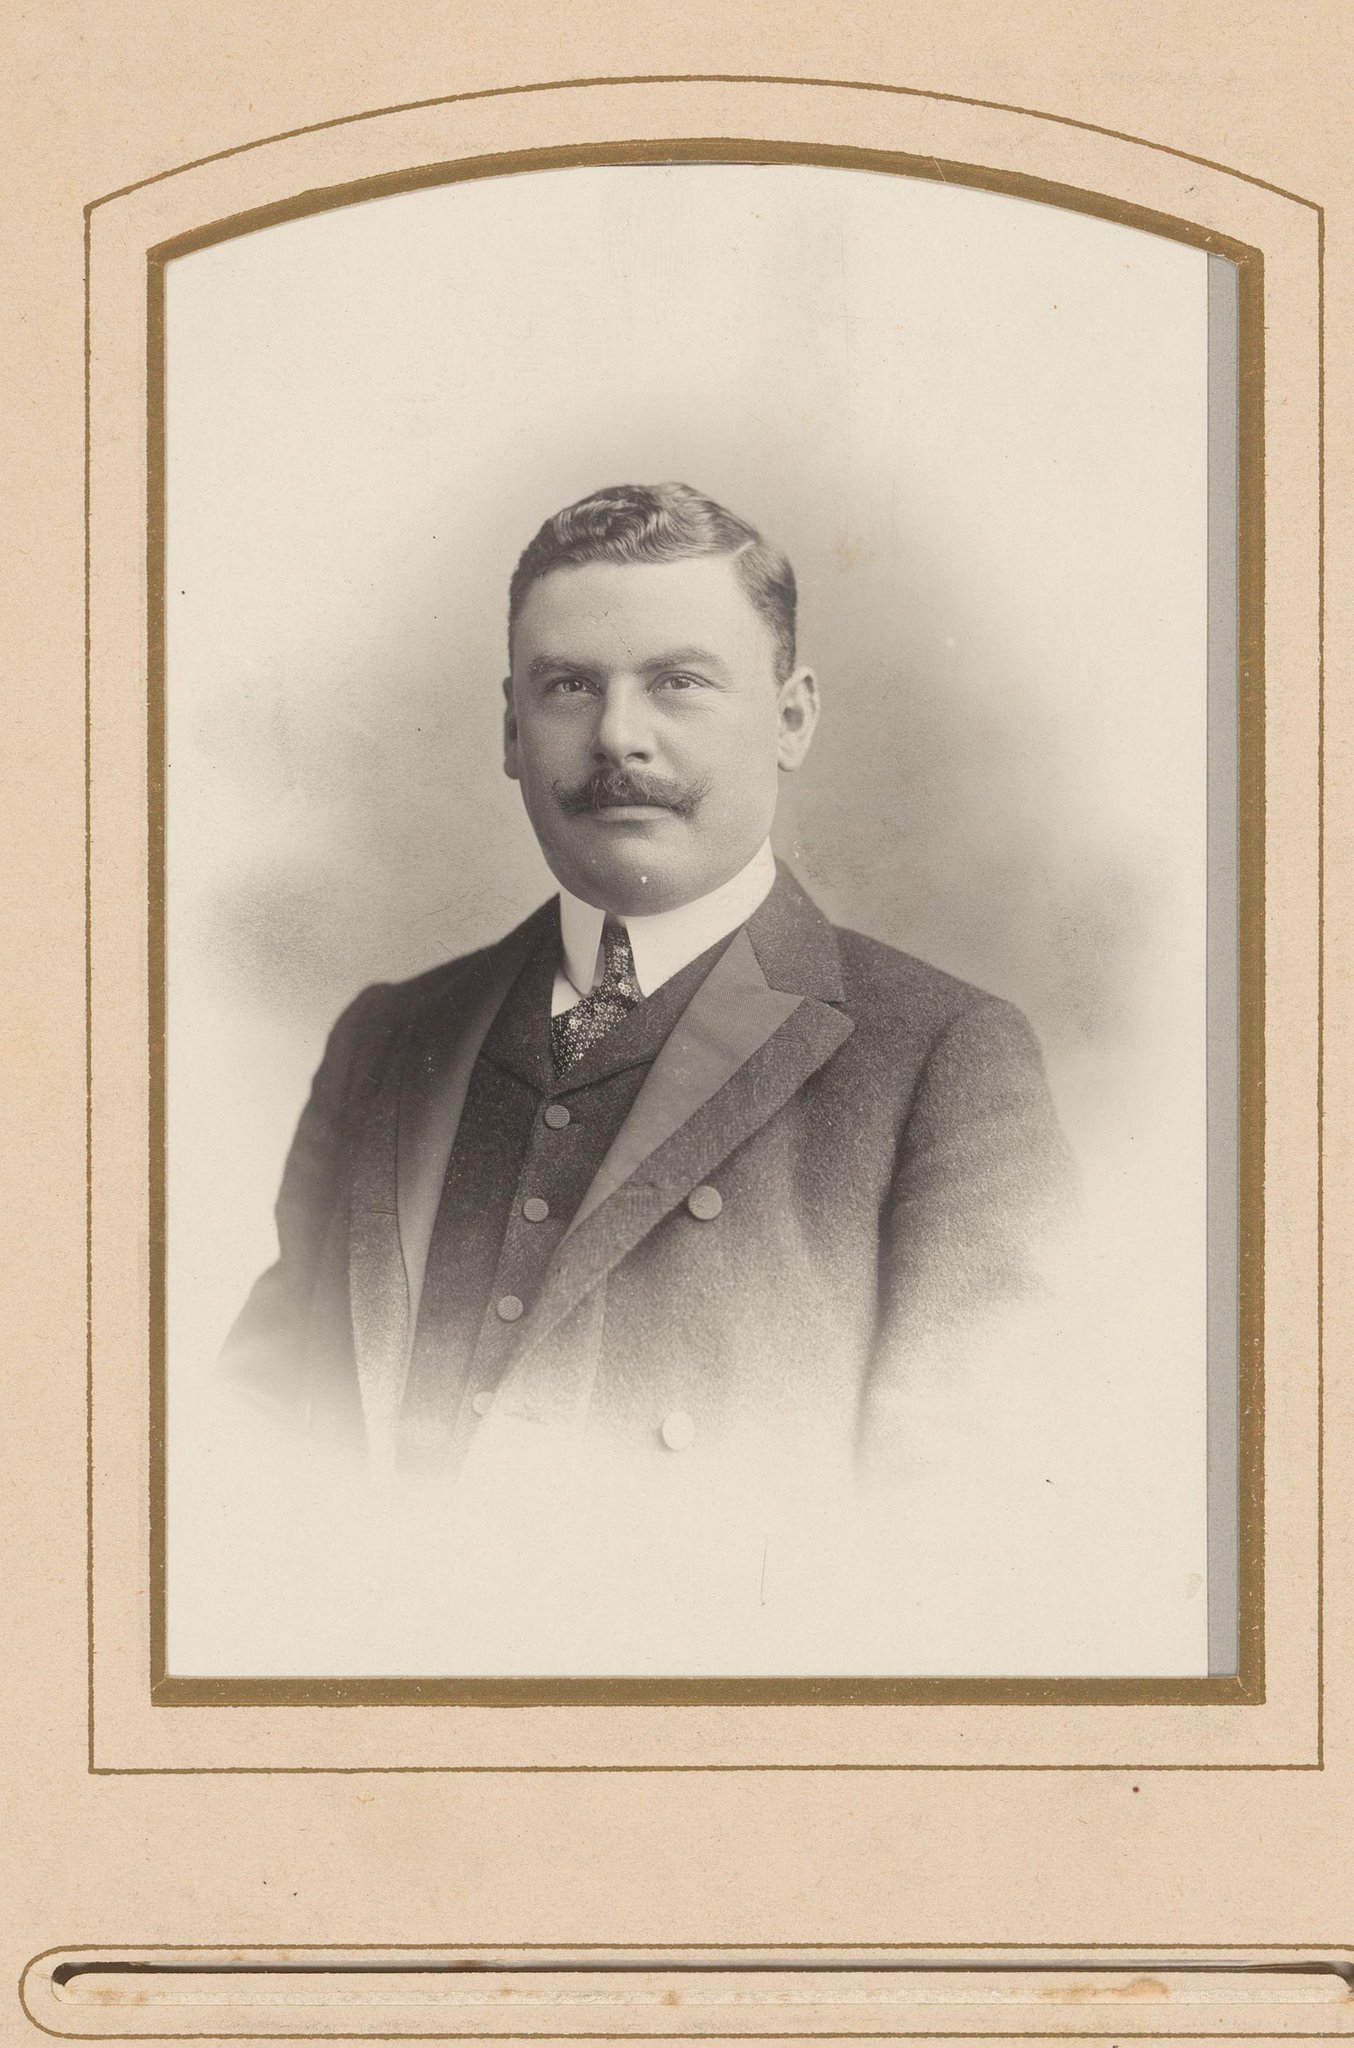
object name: cabinet photograph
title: Portret van een man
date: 1903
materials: cardboard, photographic support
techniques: gelatin silver print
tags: moustache, adult man, historical persons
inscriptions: inscription: ‘57 St Pauls Churchyard/ 61 Cheapside E.C. Emberson&Sons 11 Wilton Rd S.W./ and Certsey Surrey’, annotation: ‘Yours faithfully/ [...]/ 20 Oct 1903/ 36803’